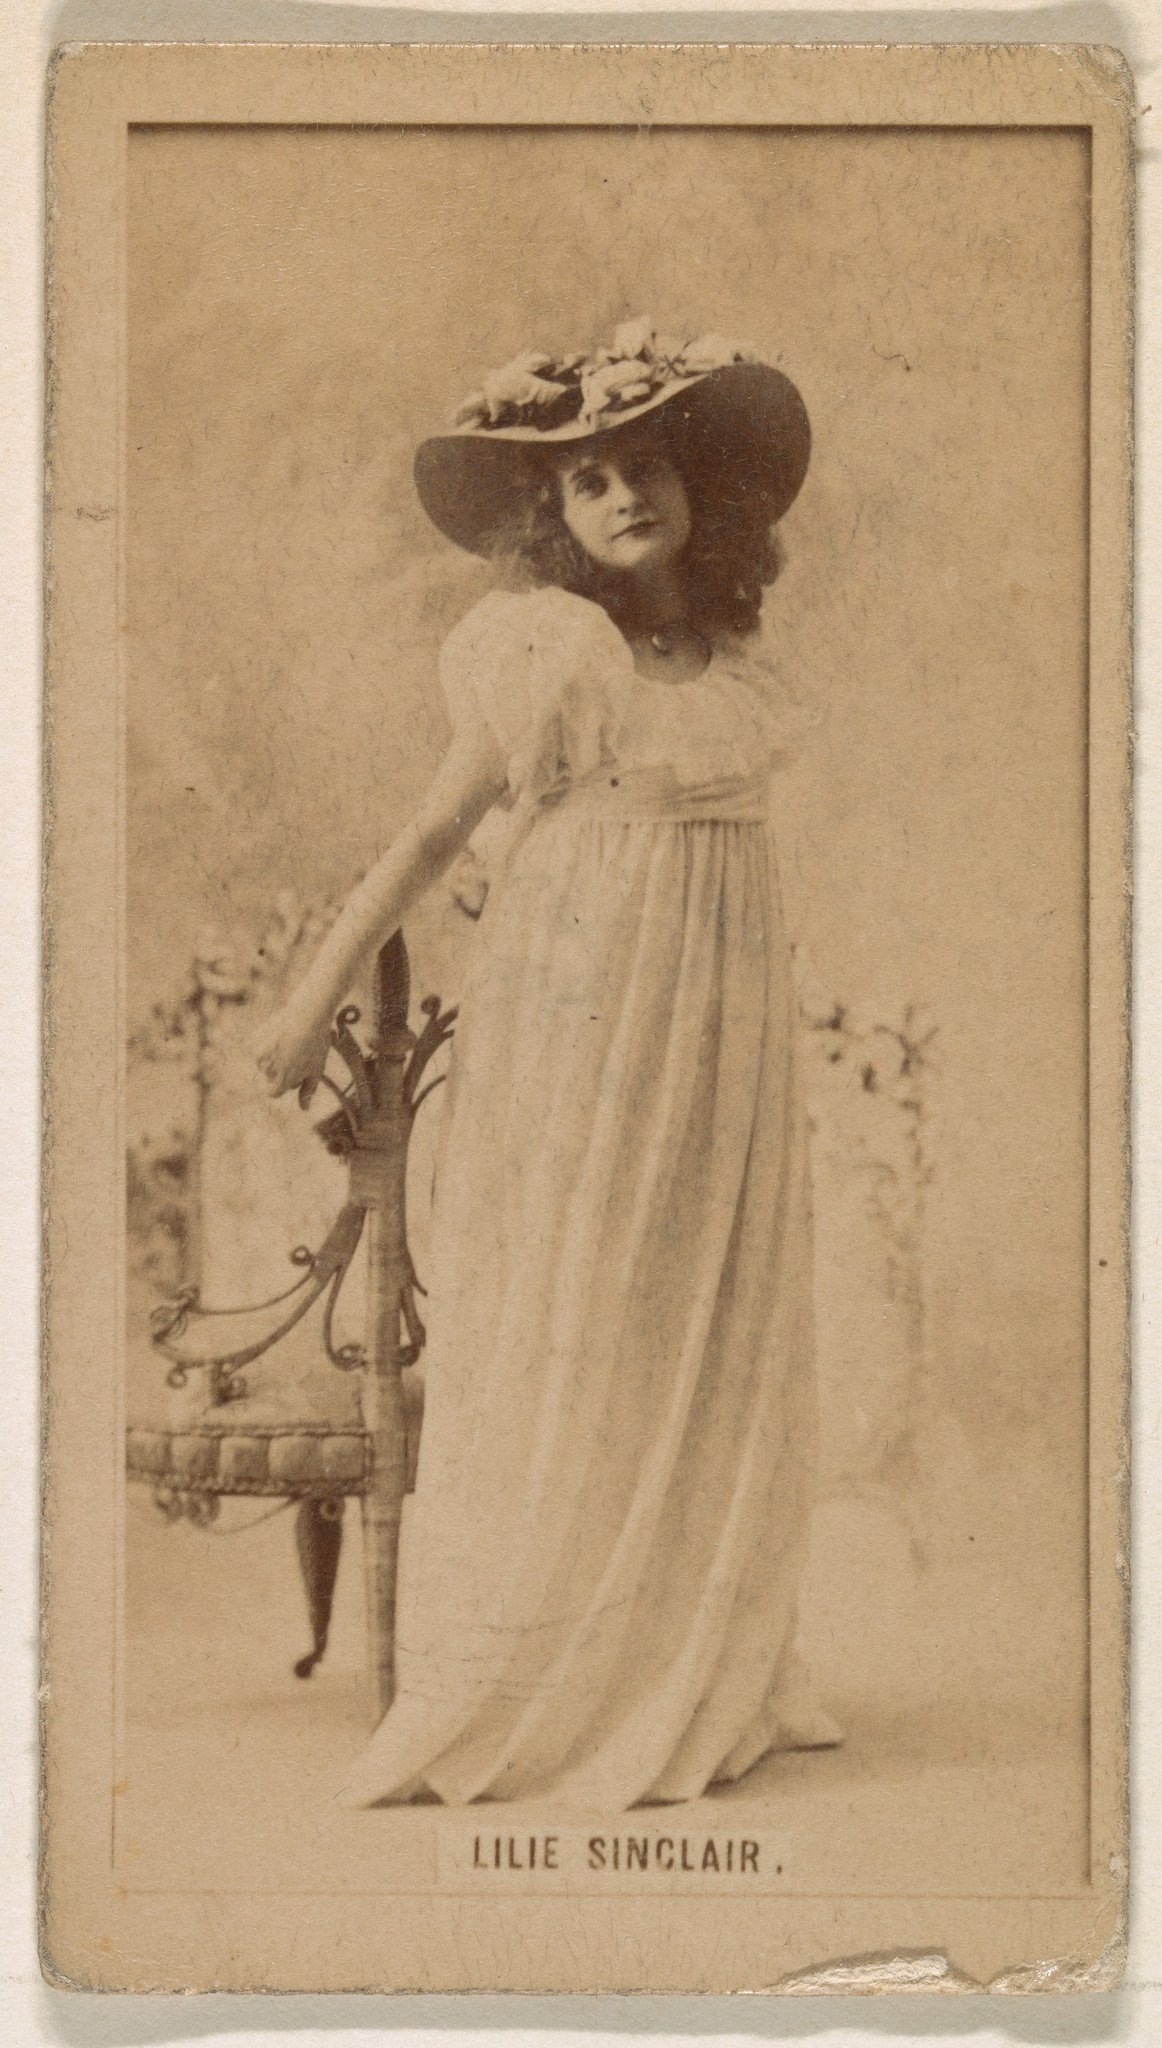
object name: photograph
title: Lilie Sinclair, from the Actresses series (N245) issued by Kinney Brothers to promote Sweet Caporal Cigarettes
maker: kinney brothers tobacco company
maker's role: publisher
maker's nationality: american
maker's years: 1869-2011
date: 1890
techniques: albumen silver print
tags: portraits,women,actresses